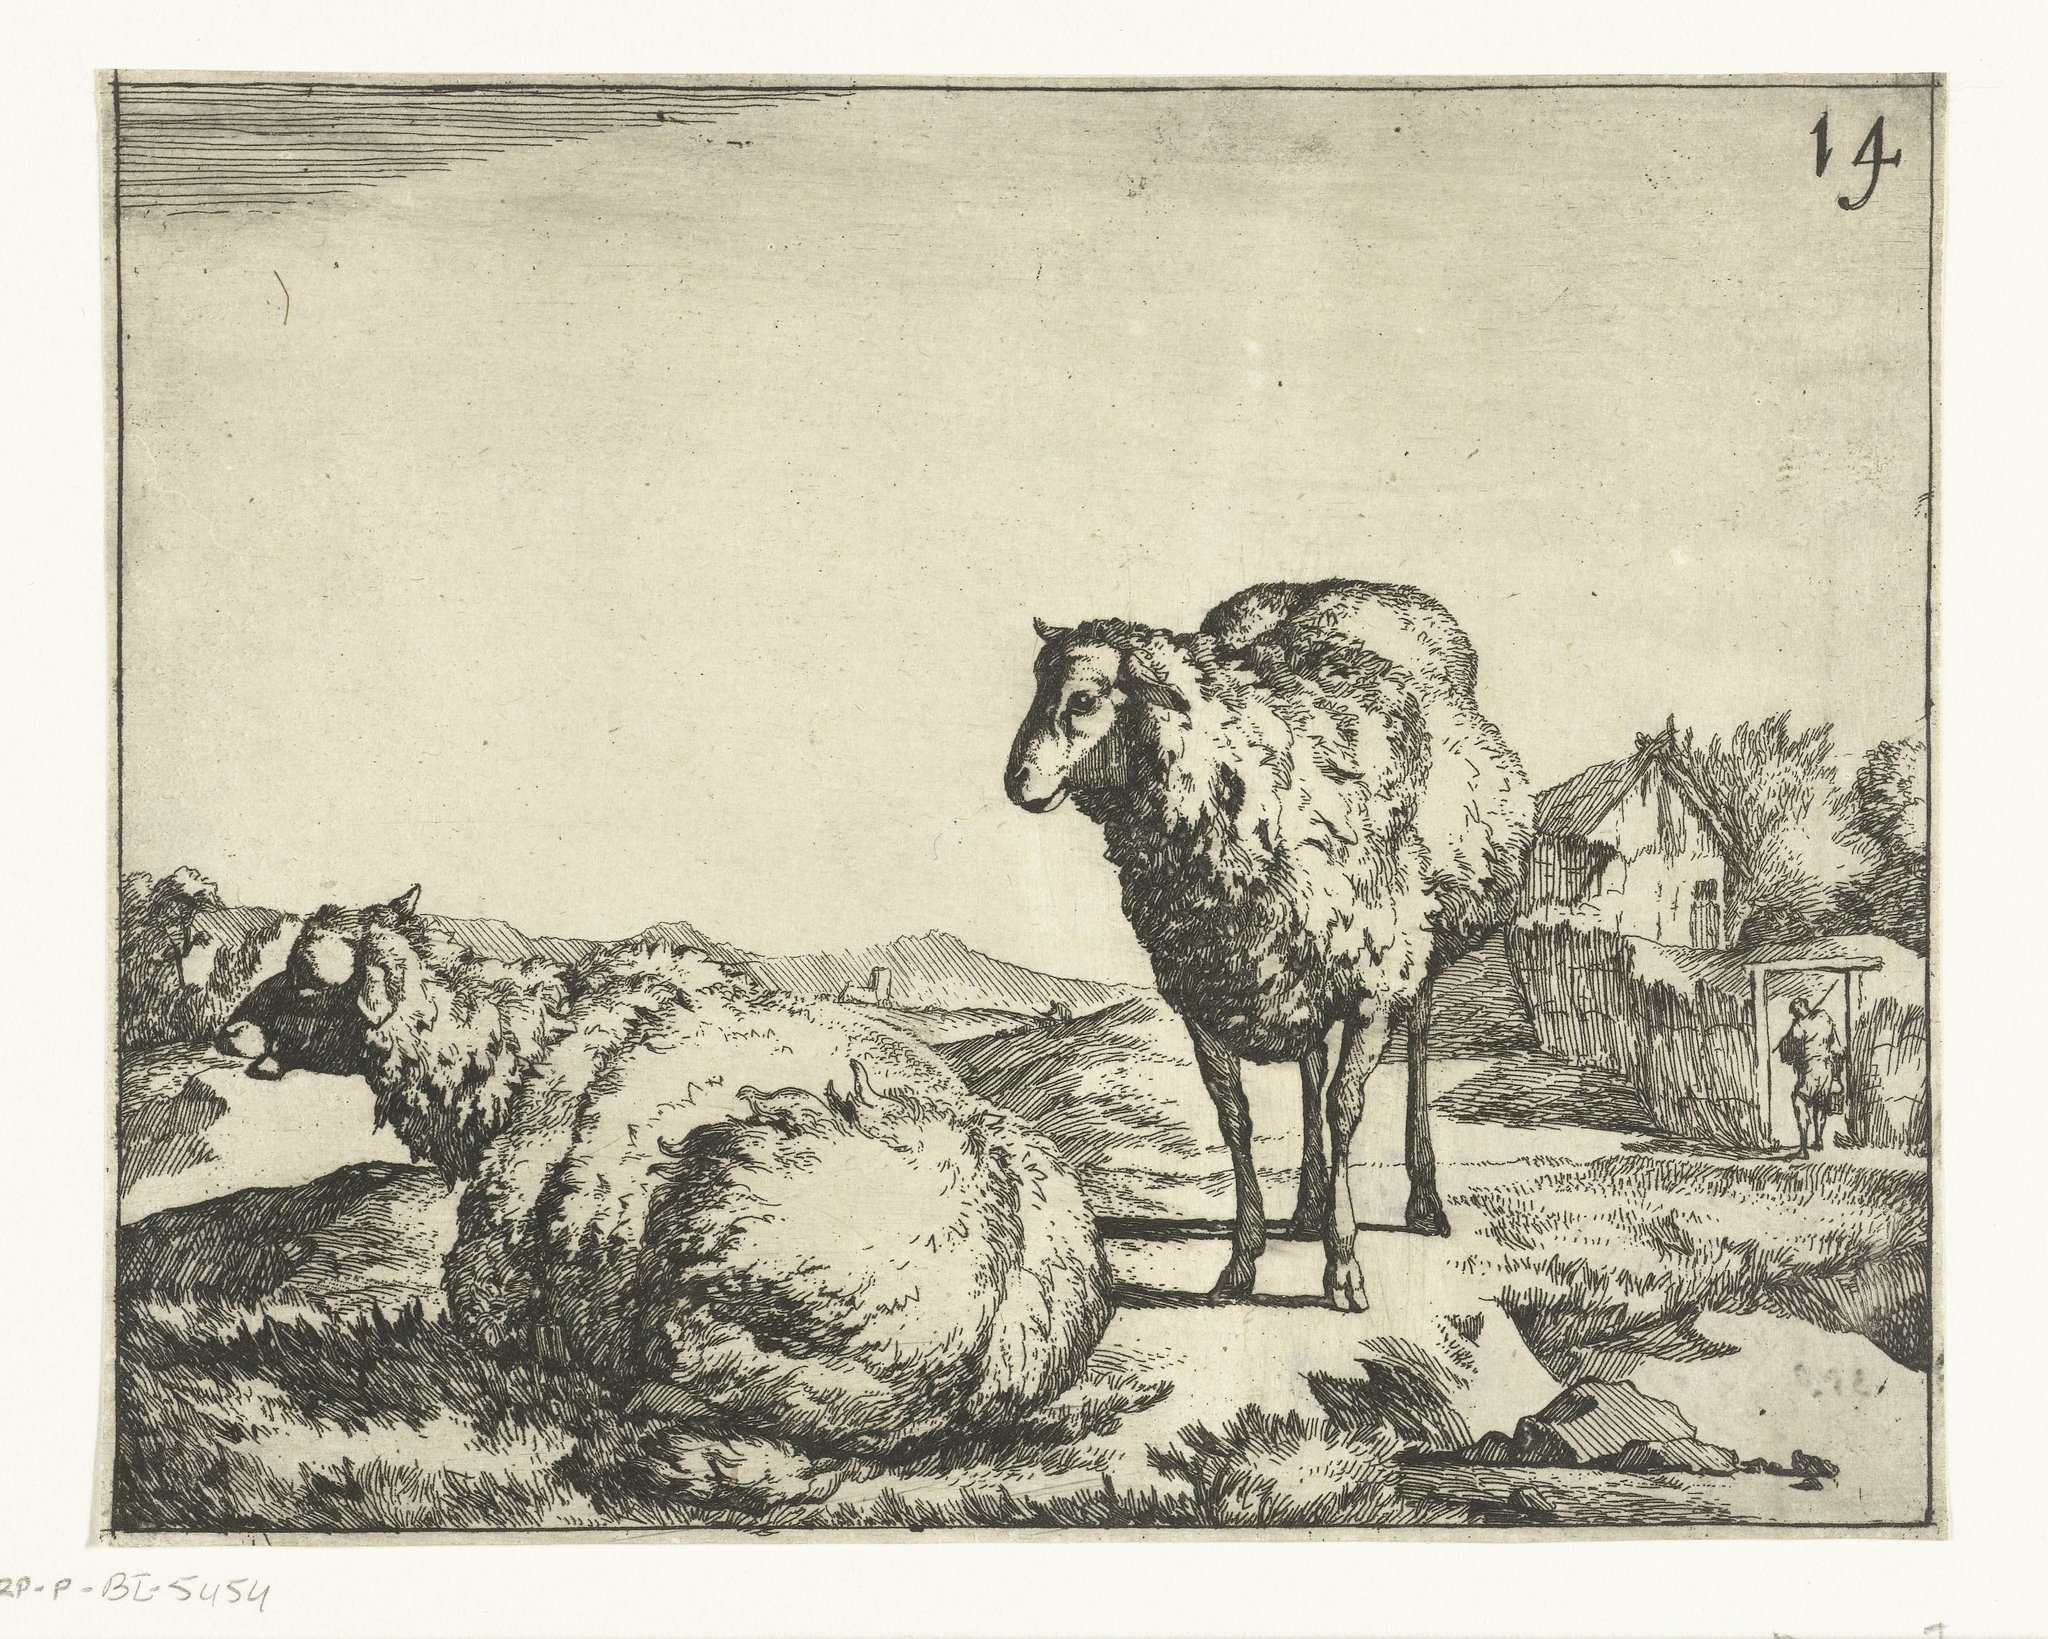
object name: print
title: Schapen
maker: marcus de bye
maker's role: print maker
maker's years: 1639-1688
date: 1660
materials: paper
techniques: etching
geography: the hague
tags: sheep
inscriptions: collector's mark: Lugt 2228